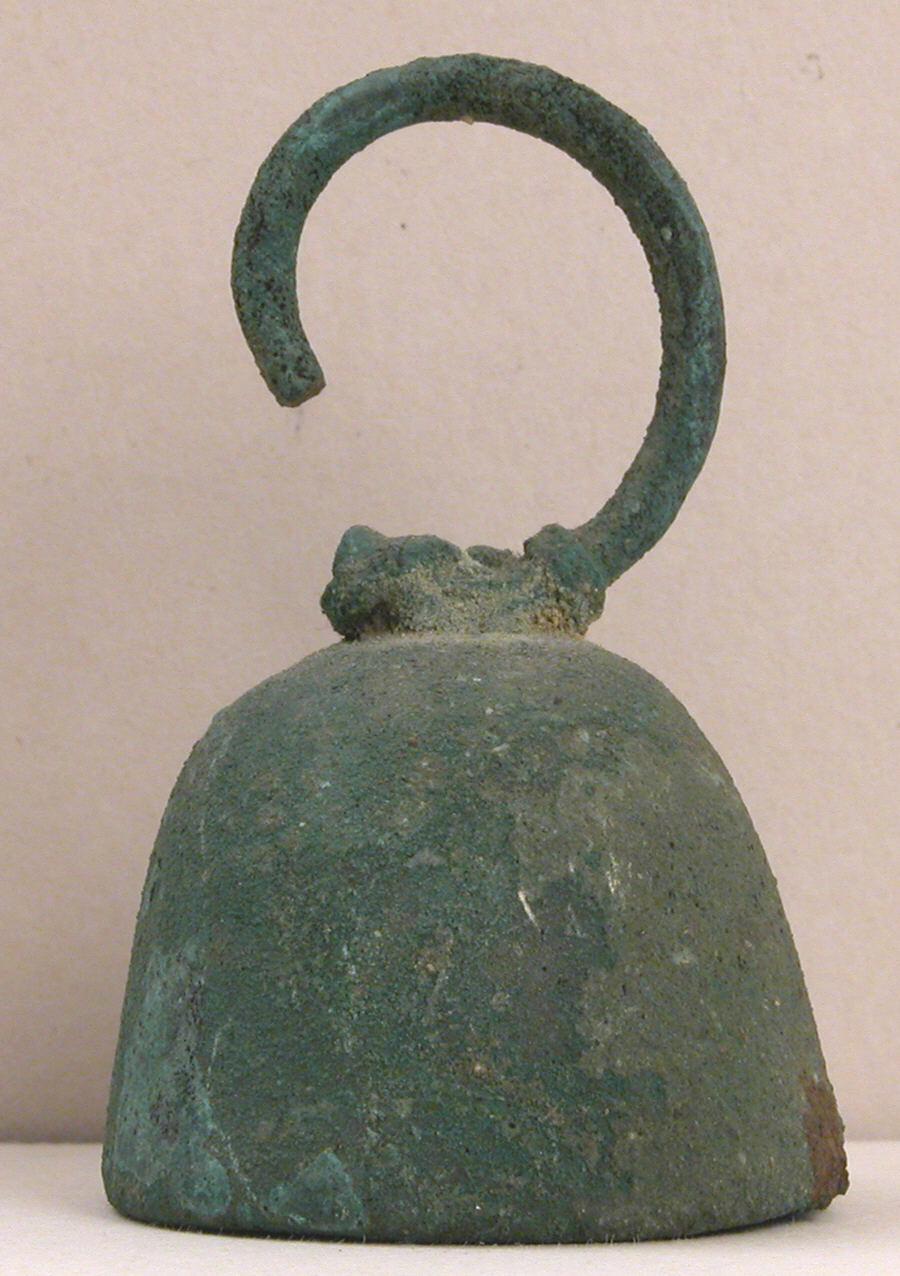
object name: bell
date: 401-800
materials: bronze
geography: palestine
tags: musical instruments